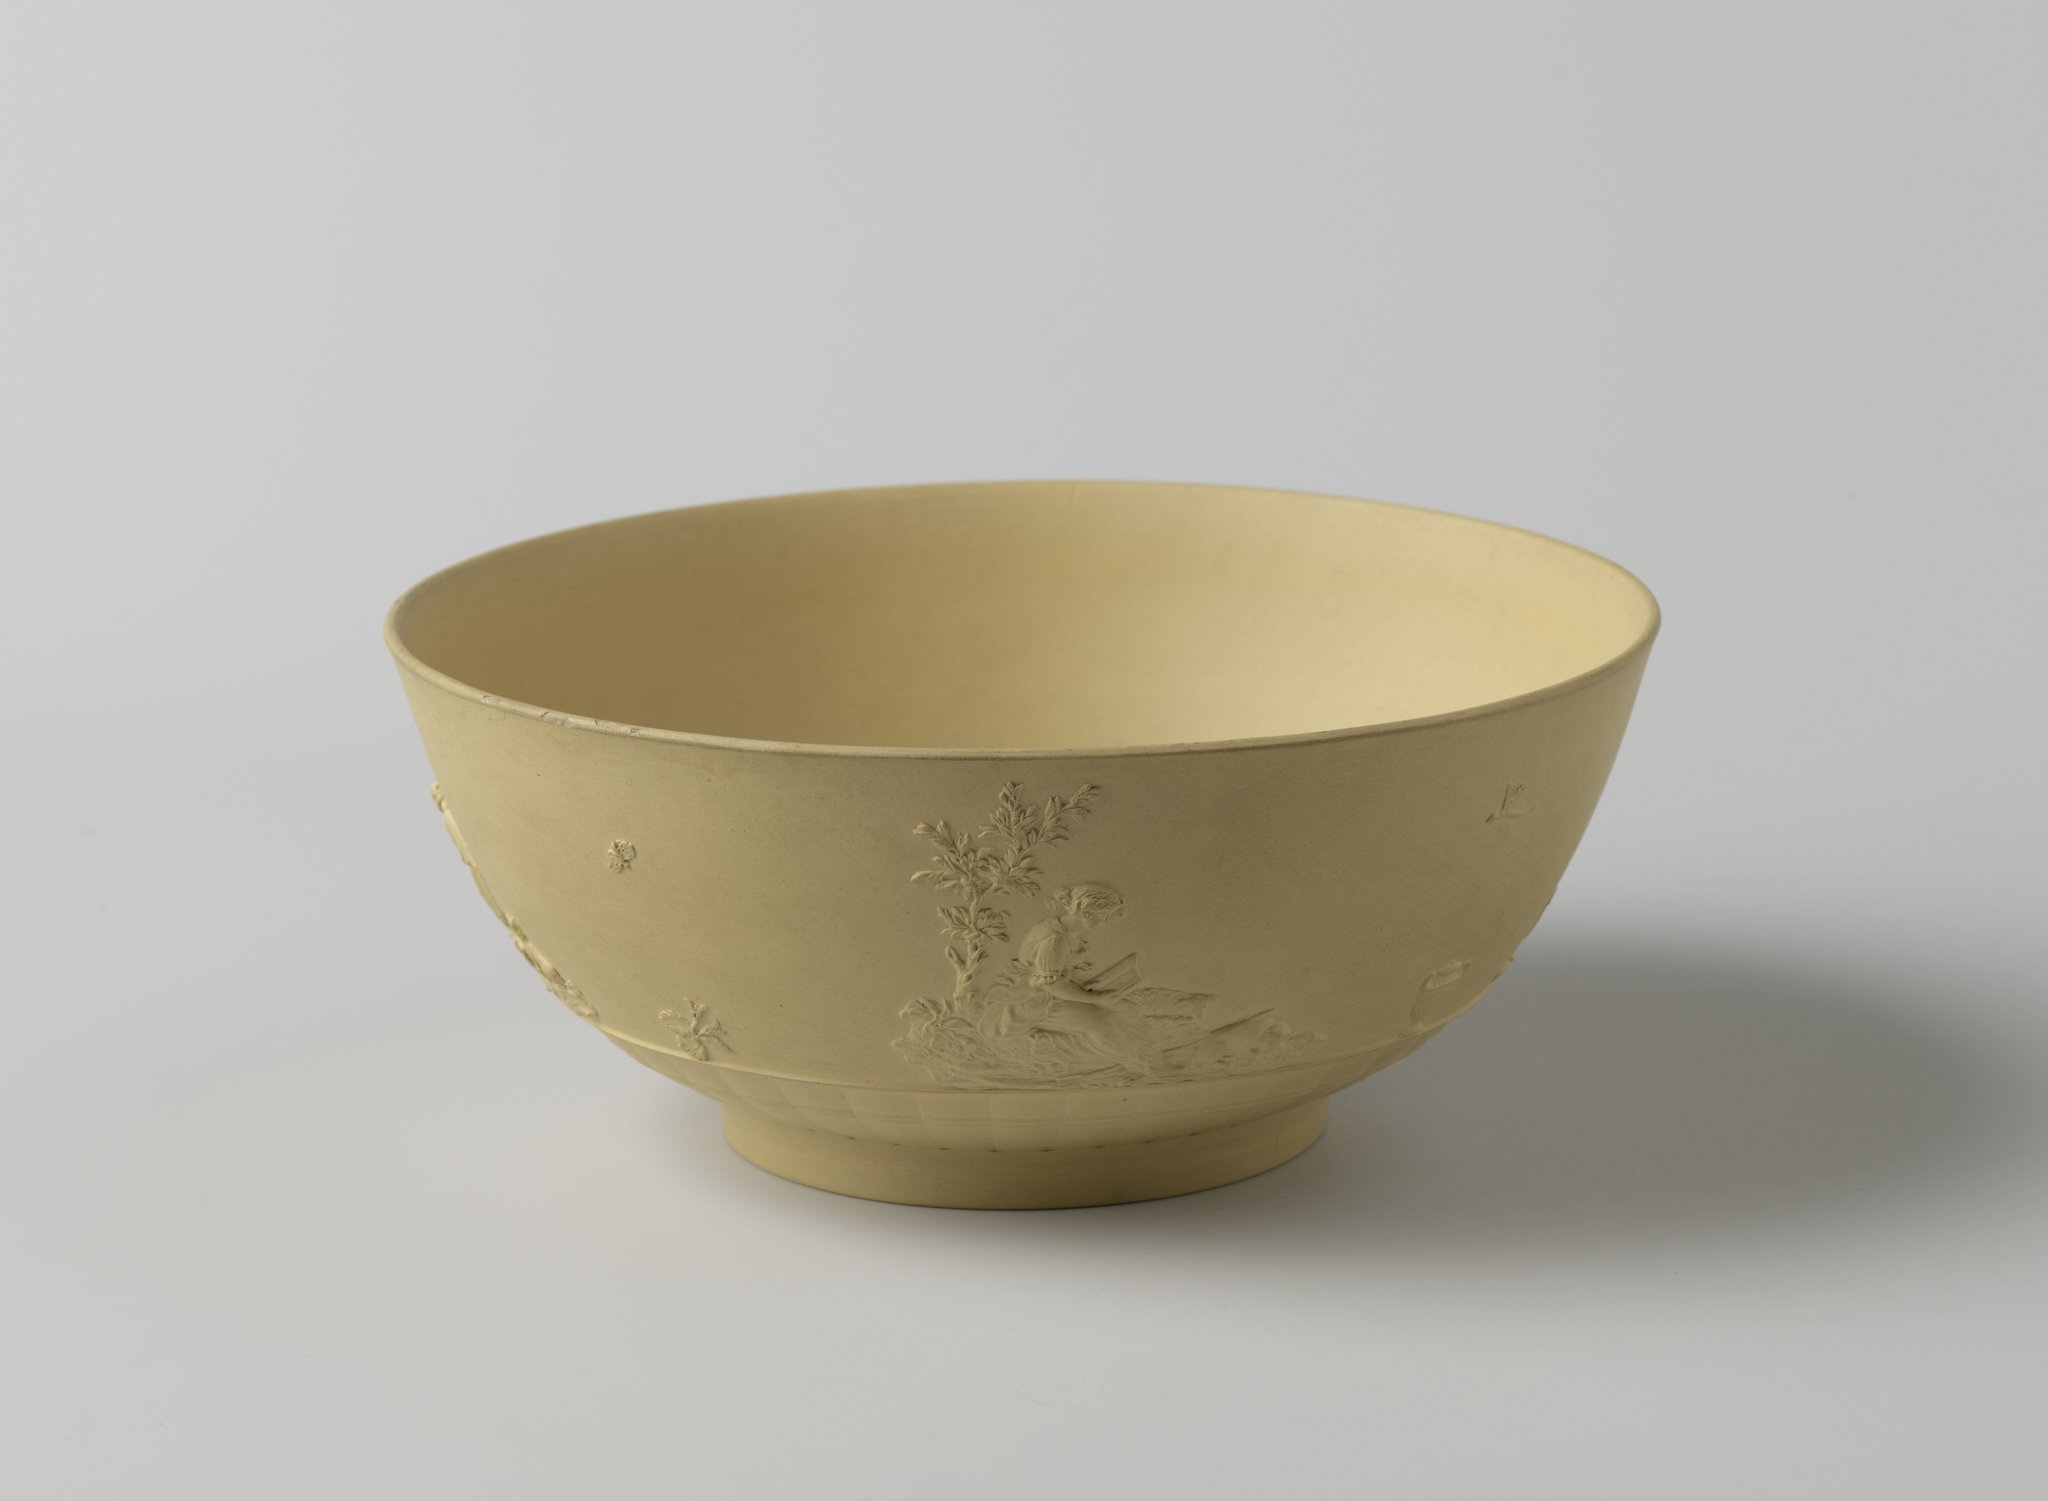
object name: bowl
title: Kom van aardewerk, Turner type Black Basalt.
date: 1780-1800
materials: earthenware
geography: england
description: Kom van Engels aardewerk, met reliëfs op beige ondergrond van een lezende, zittende, treurende en knielende vrouw in klassieke stijl. De lezende vrouw zit onder een boom, de zittende vrouw speelt met een amortje, de treurende vrouw zit onder een boom met een hond en de knielende vrouw voor een altaar waarop een vaas. Tussen deze voorstellingen eveneens in reliëf: een plant en een vlinder, een vaas en een libel en een bloempot en een vogel. Onderaan de kom een gekanneleerde rand en rechtopstaande onversierde rand als voet. Gemerkt: Turner.